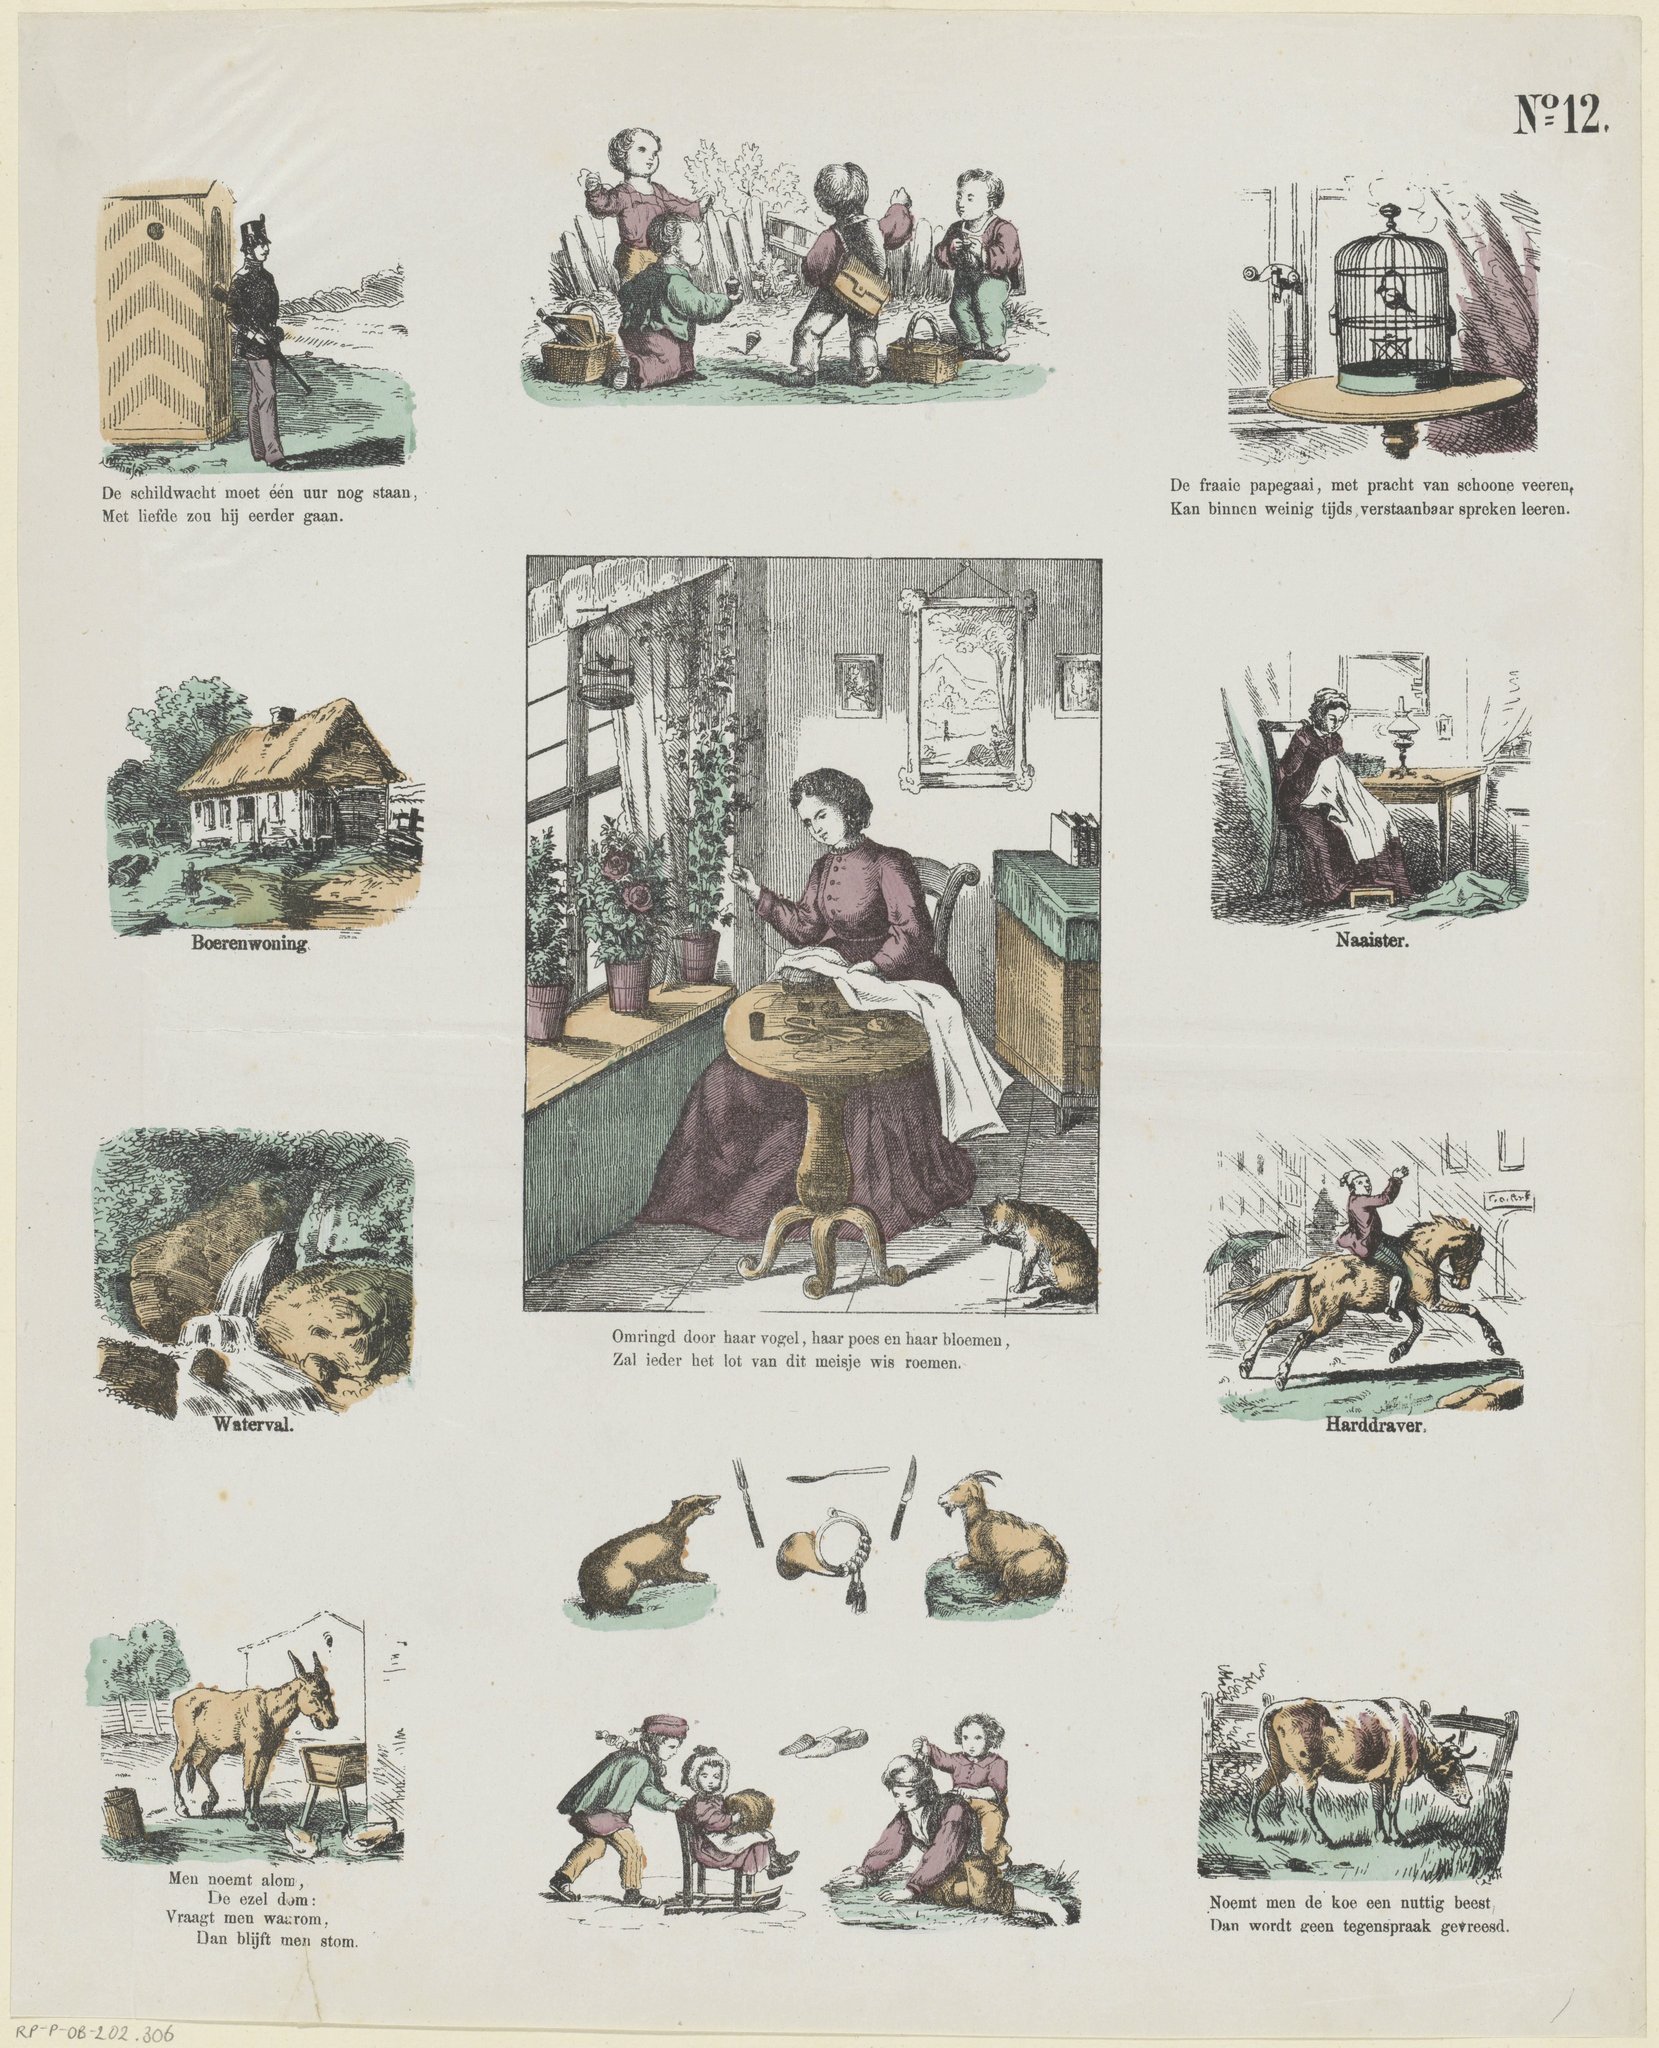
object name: popular print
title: Meijer's prenten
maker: Anonymous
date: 1873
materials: paper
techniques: colour, letterpress printing, lithograph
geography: amsterdam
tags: children's games and plays, animals, crafts and industries, guard duty, keeping sentry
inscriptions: collector's mark: Lugt 2760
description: Blad met 12 voorstellingen van verschillende aard, waaronder een schildwacht, spelende kinderen en een naaister. Onder enkele afbeeldingen een onderschrift. Genummerd rechtsboven: No. 12.